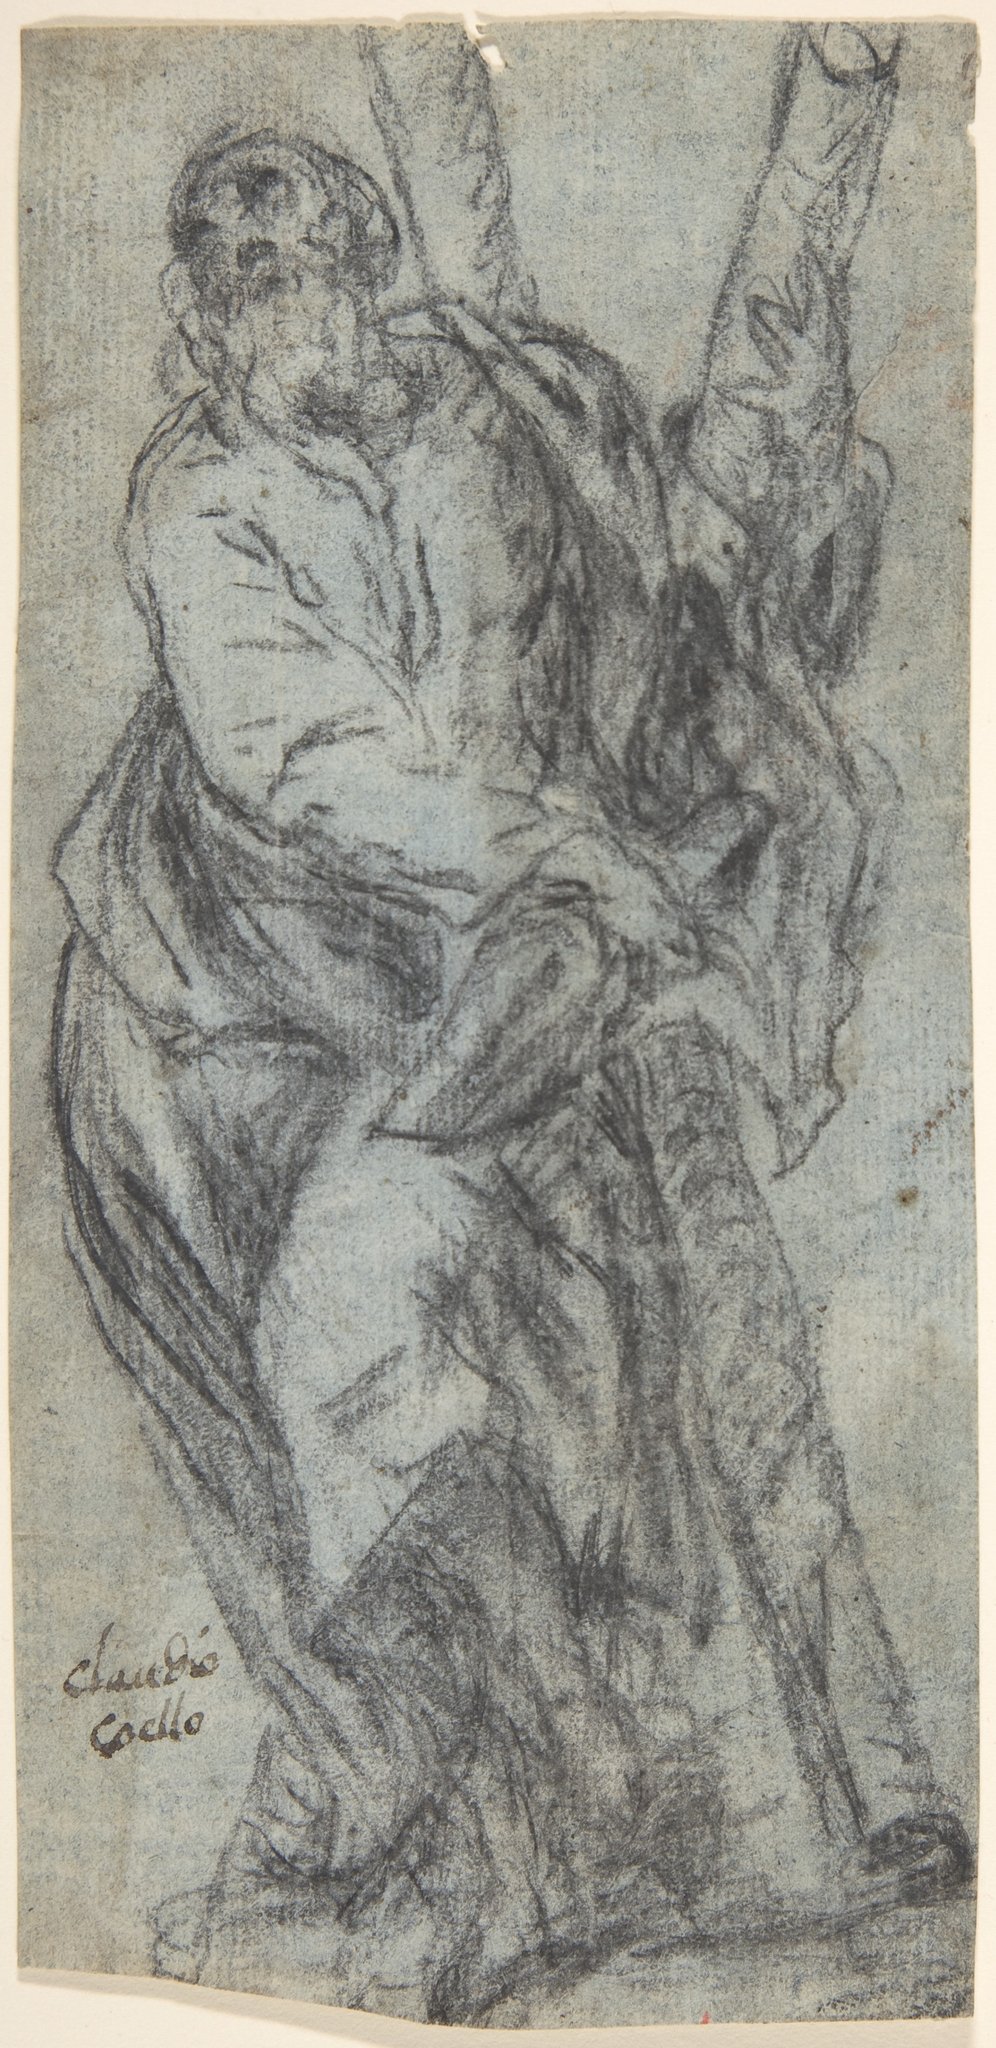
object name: drawing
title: St. Andrew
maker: juan carreño de miranda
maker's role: artist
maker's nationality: spanish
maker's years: 1614-1685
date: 1601-1700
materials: charcoal, paper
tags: men,saints